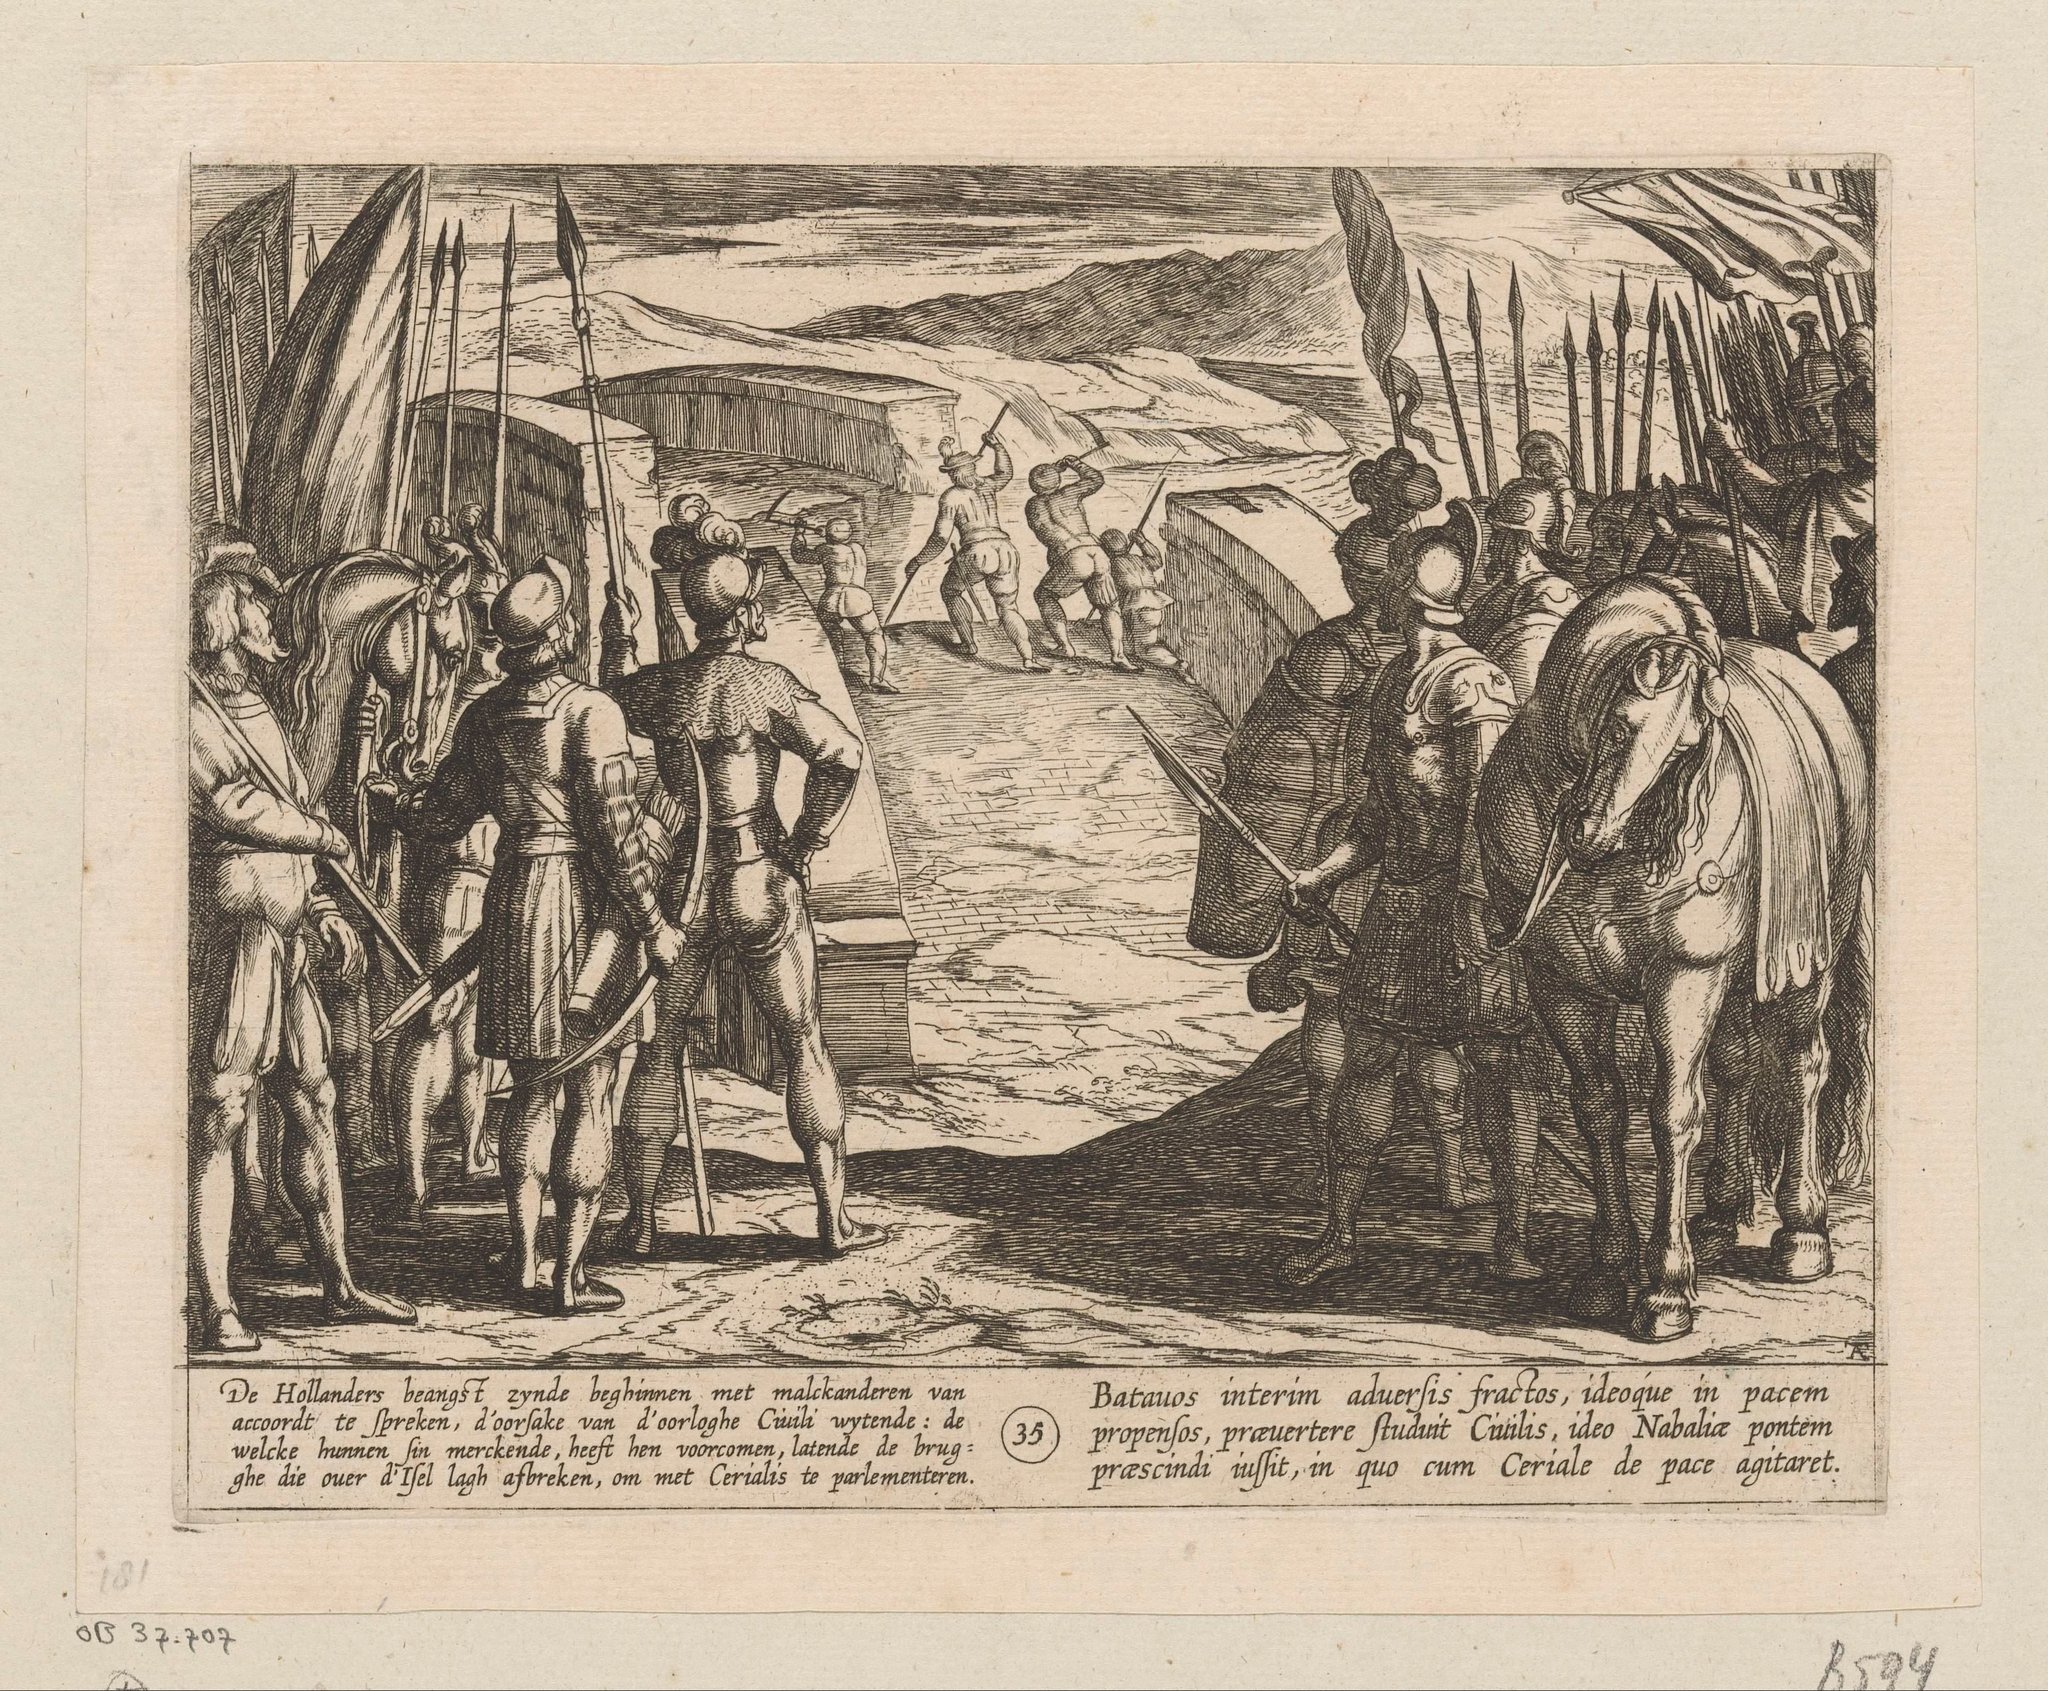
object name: history print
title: De Bataafse Opstand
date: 1612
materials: paper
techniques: etching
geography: italy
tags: battle, fighting in general, extinct, 'historical' peoples (with name)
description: Bataven worden bang en breken de brug over de IJssel af om met Cerialis te kunnen onderhandelen. Prent nummer 35 in de serie prenten over de Bataafse Opstand: Batavorum cum Romanis bellum / à Corn. Tacito lib. IV & V. : Hist. olim descriptum, figuris nunc aeneis expressum, auctore Othone Vaenio Lugdunobatava = De Batavische oft oude Hollandtsche oorloghe teghen de Romeynen. Otto Vaenius, Antwerpen 1612. Onderaan twee verzen van vier regels in het Nederlands en in het Latijn. Zonder tekst op achterzijde.